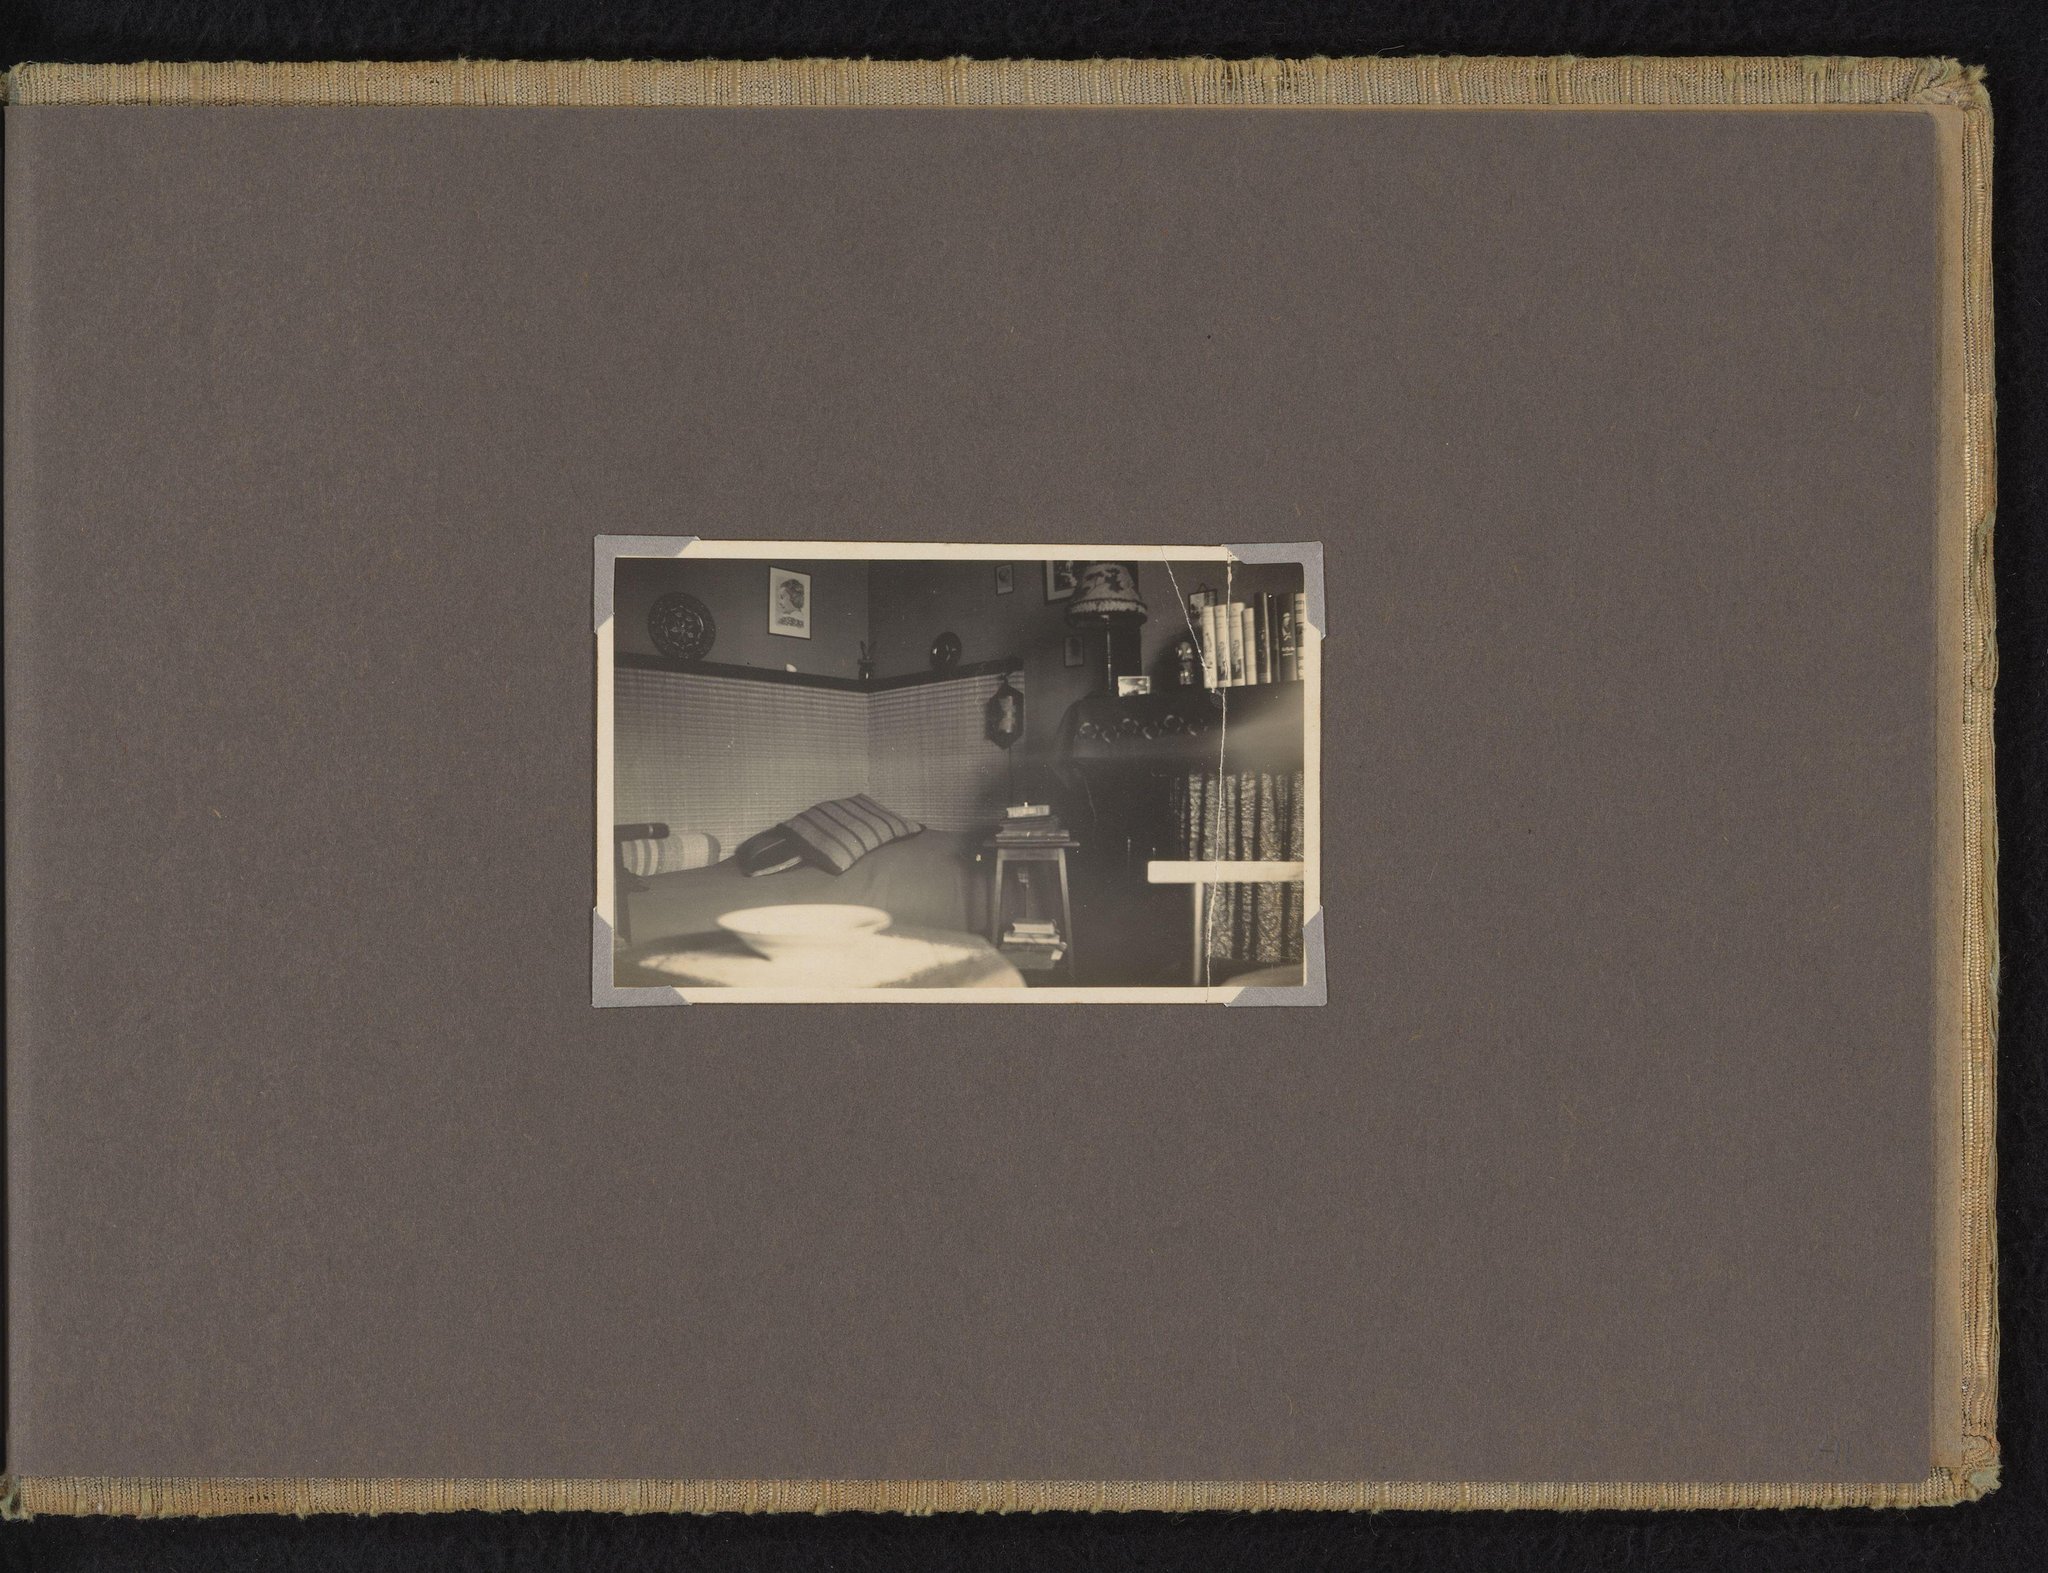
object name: photograph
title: Slaapkamer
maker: Anonymous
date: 1930-1931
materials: cardboard, photographic support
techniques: gelatin silver print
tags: bedroom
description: Albumblad met een foto van een kamer met een bed en andere spullen. Onderdeel van fotoalbum 'Studentenalbum Indologen'.